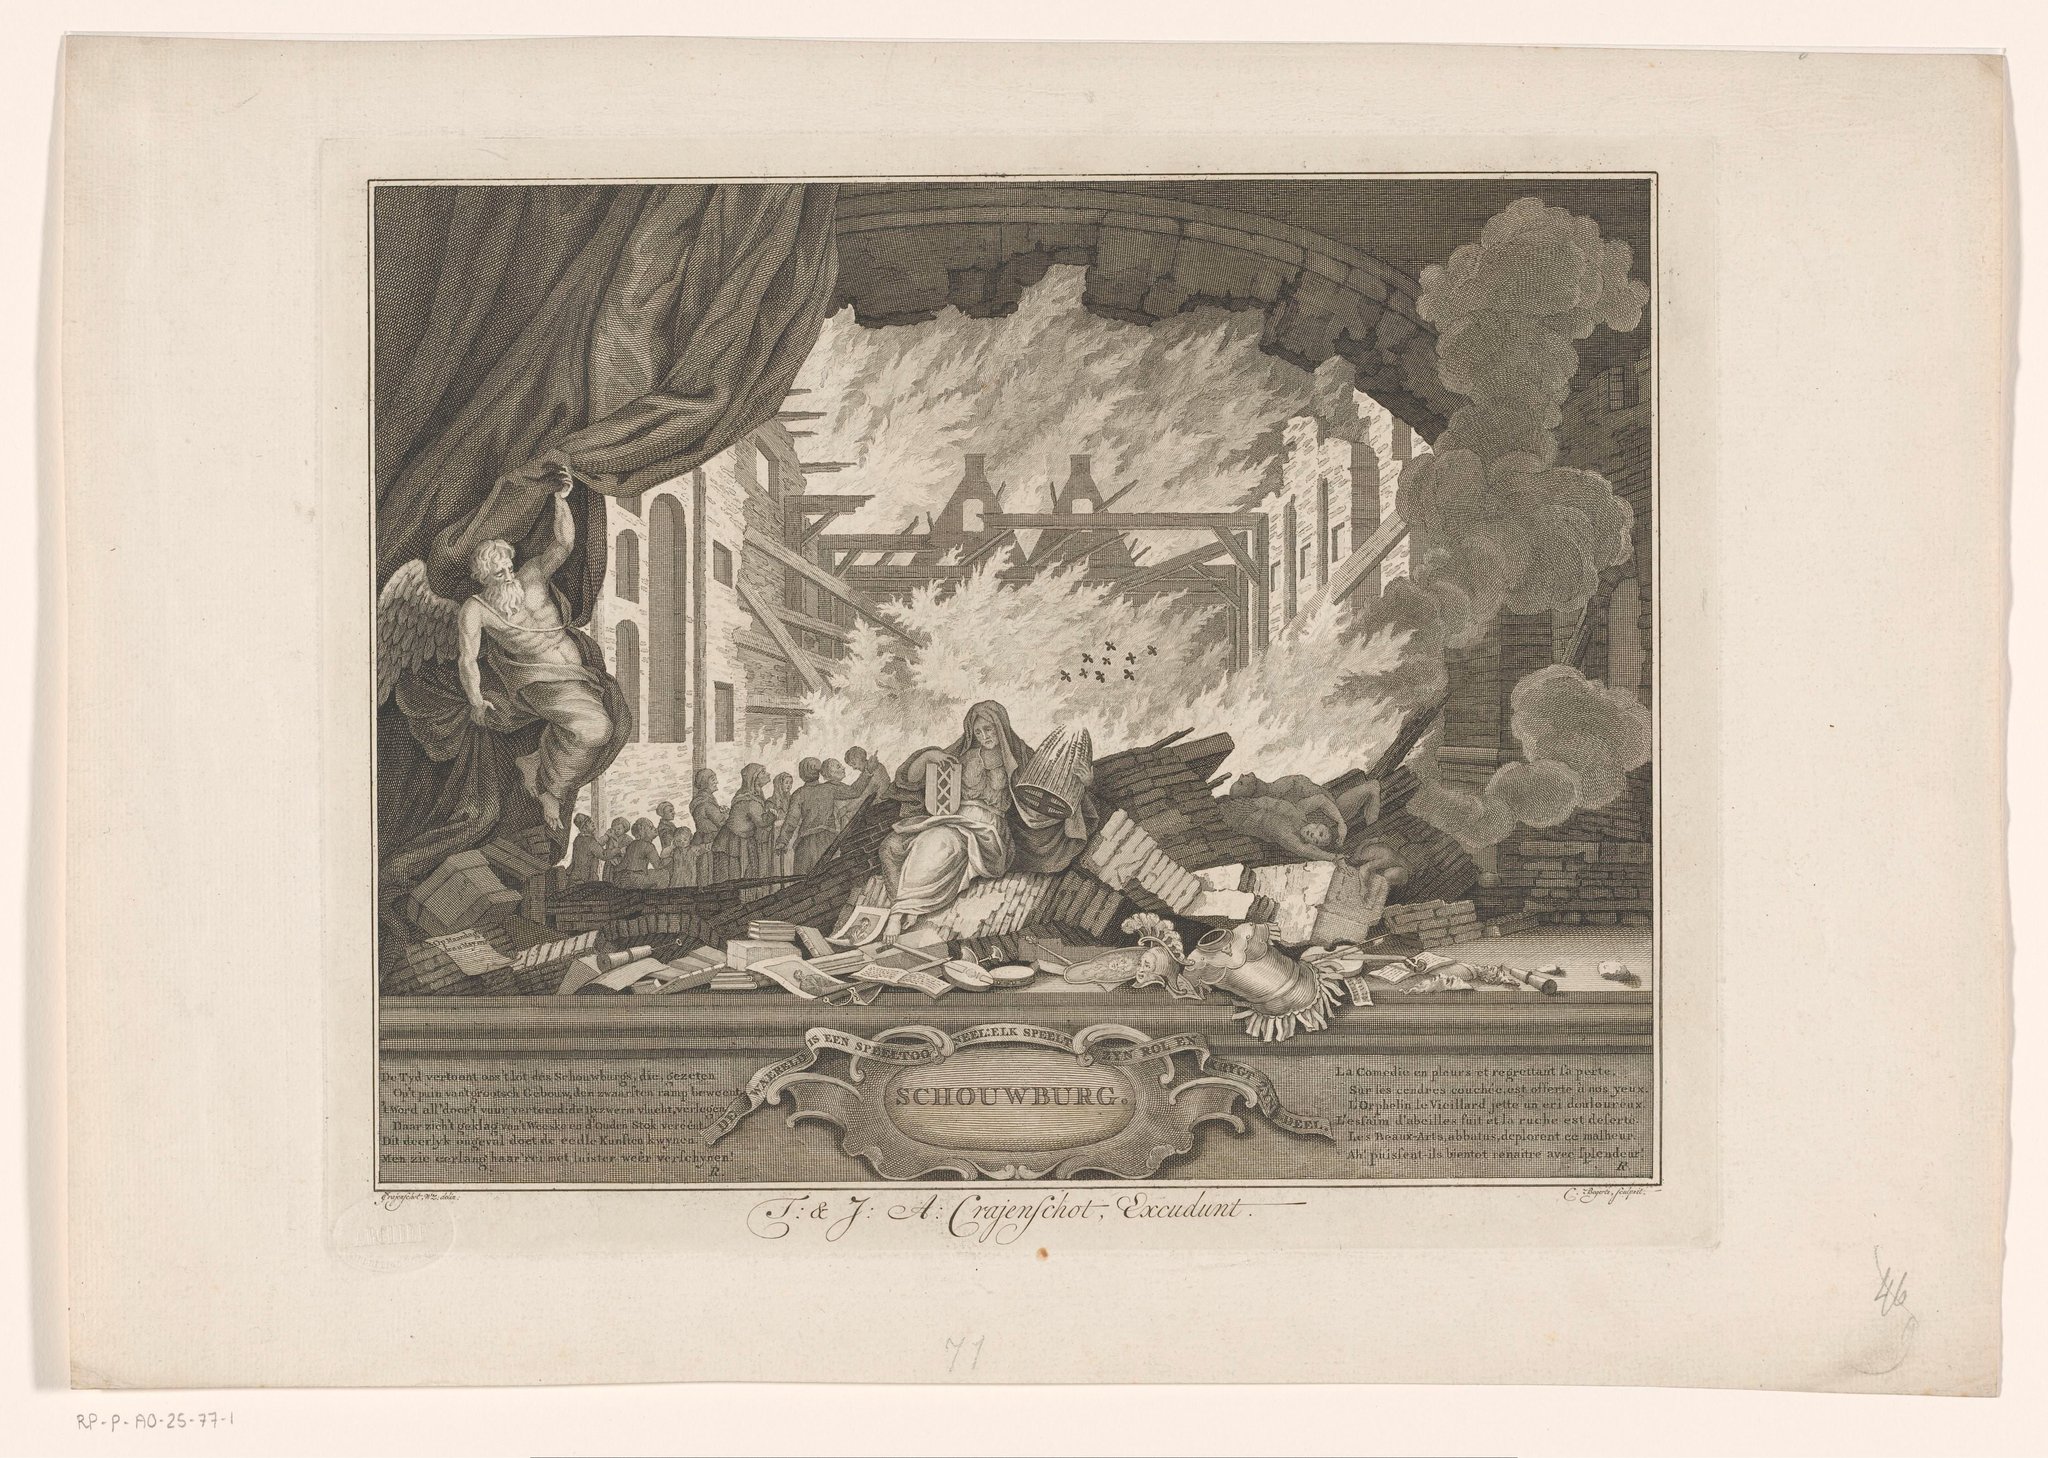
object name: titelprent, frontispice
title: Allegorie op de brand van de schouwburg aan de Keizersgracht te Amsterdam, 1772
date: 1772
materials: paper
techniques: engraving, etching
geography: amsterdam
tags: on fire, ablaze, theatre, theatrical performance, theatre (building), father time, man with wings and scythe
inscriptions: check stamp: ‘Archief Ministerie van Oorlog Afdeeling Genie’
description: Titelprent voor de serie van vier prenten over de brand in de Amsterdamse Schouwburg aan de Keizersgracht op 11 mei 1772. Vader Tijd trekt het gordijn van het ruïneuze toneel opzij om de brandende schouwburg te onthullen. Te midden van de ruïnes zit de bedroefde personificatie van de Amsterdamse Schouwburg met het wapen van de stad en een verbrande bijenkorf, waaruit de bijen zijn ontsnapt, in haar handen. Onder het toneel een cartouche met de titel en het bekende vers van Vondel ('De waereld is een speeltooneel: elk speelt zyn rol en krygt zyn deel'). Links en rechts daarvan een zesregelig vers in het Nederlands (links) en Frans (rechts).